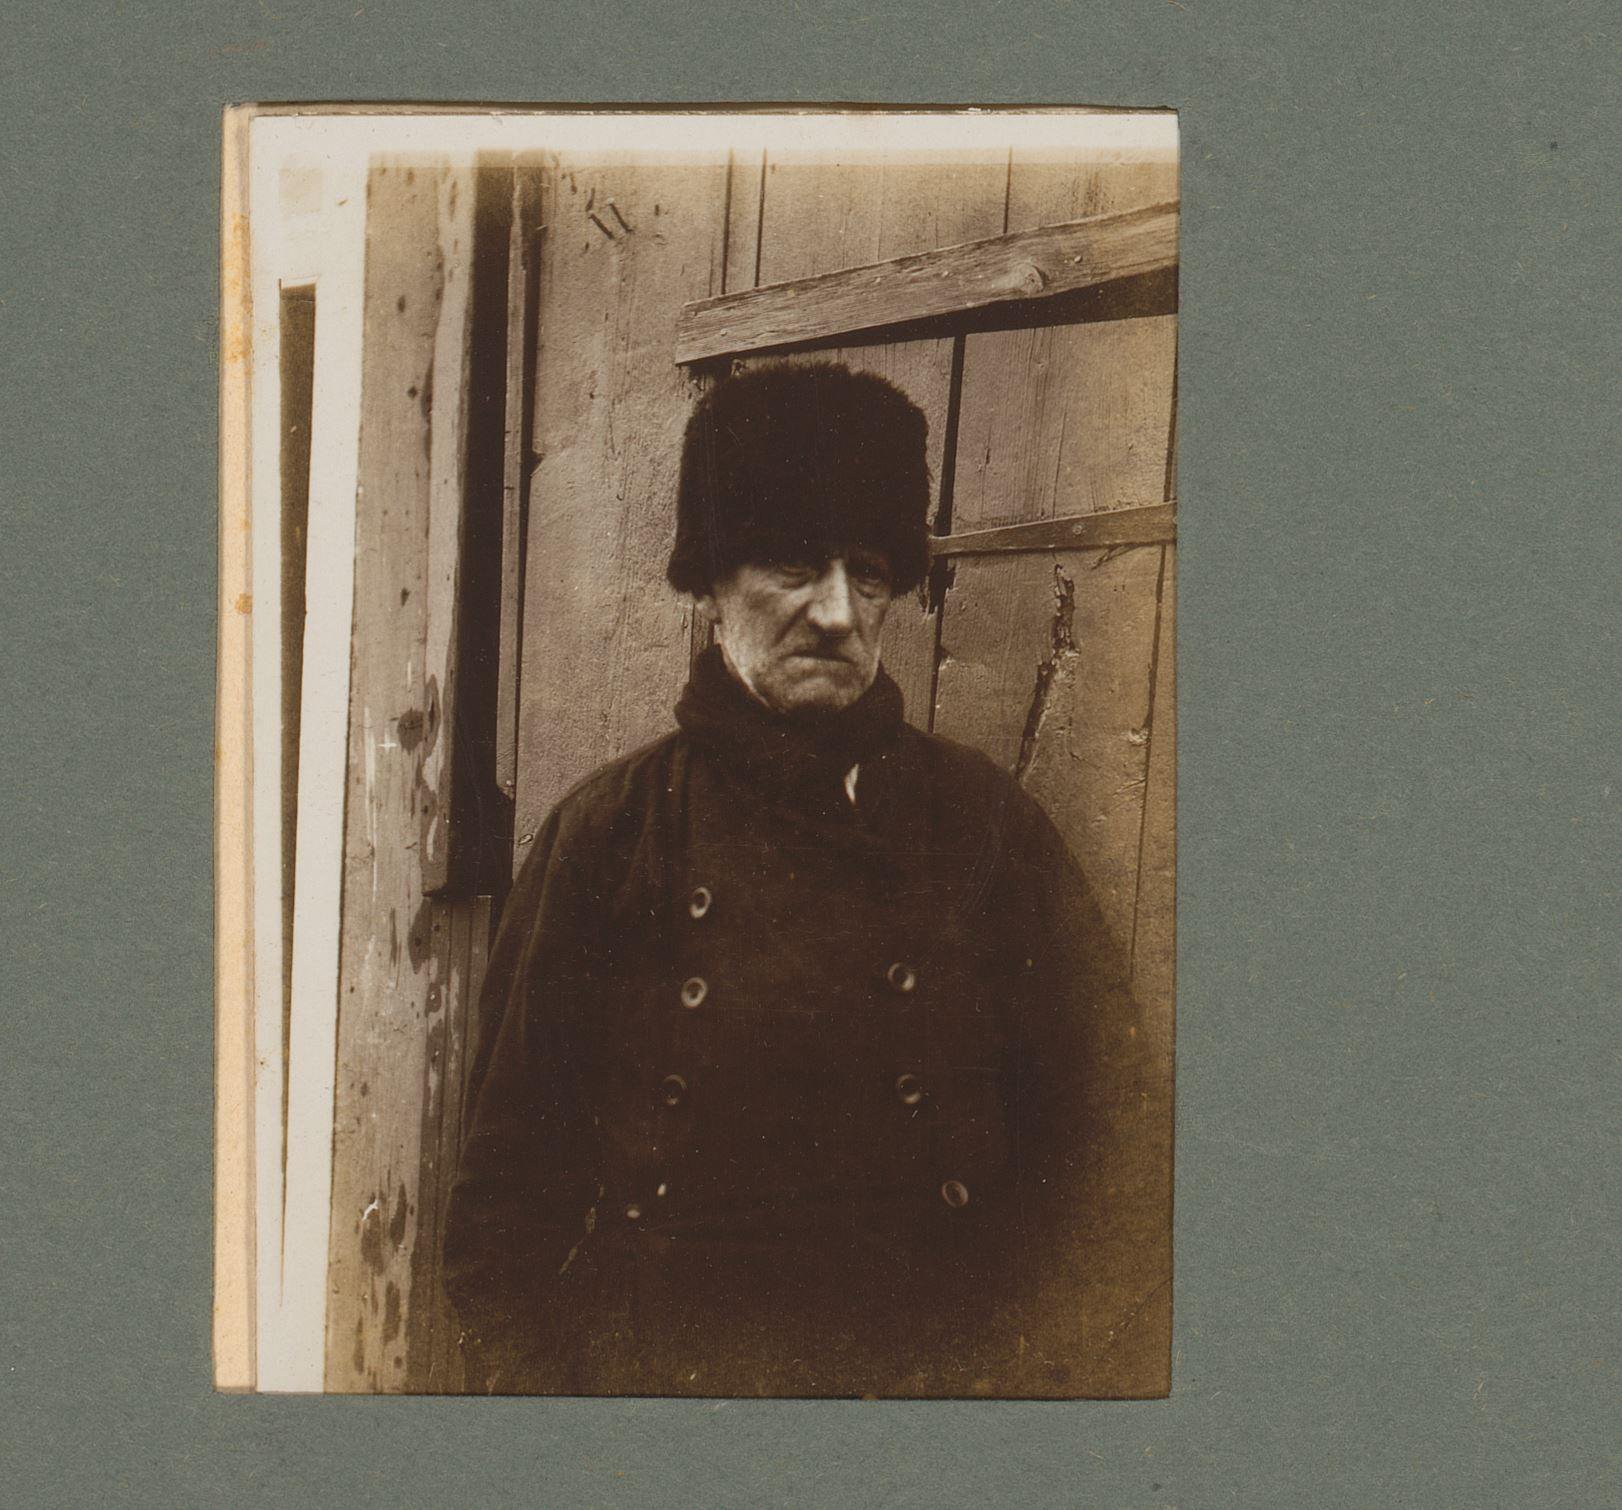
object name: album leaf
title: Portret van een man met een donkere jas en muts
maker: george hidderley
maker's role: fotograaf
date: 1920-1940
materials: photographic support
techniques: gelatin silver print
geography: netherlands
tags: coat: overcoat, adult man, historical persons, head-gear: cap